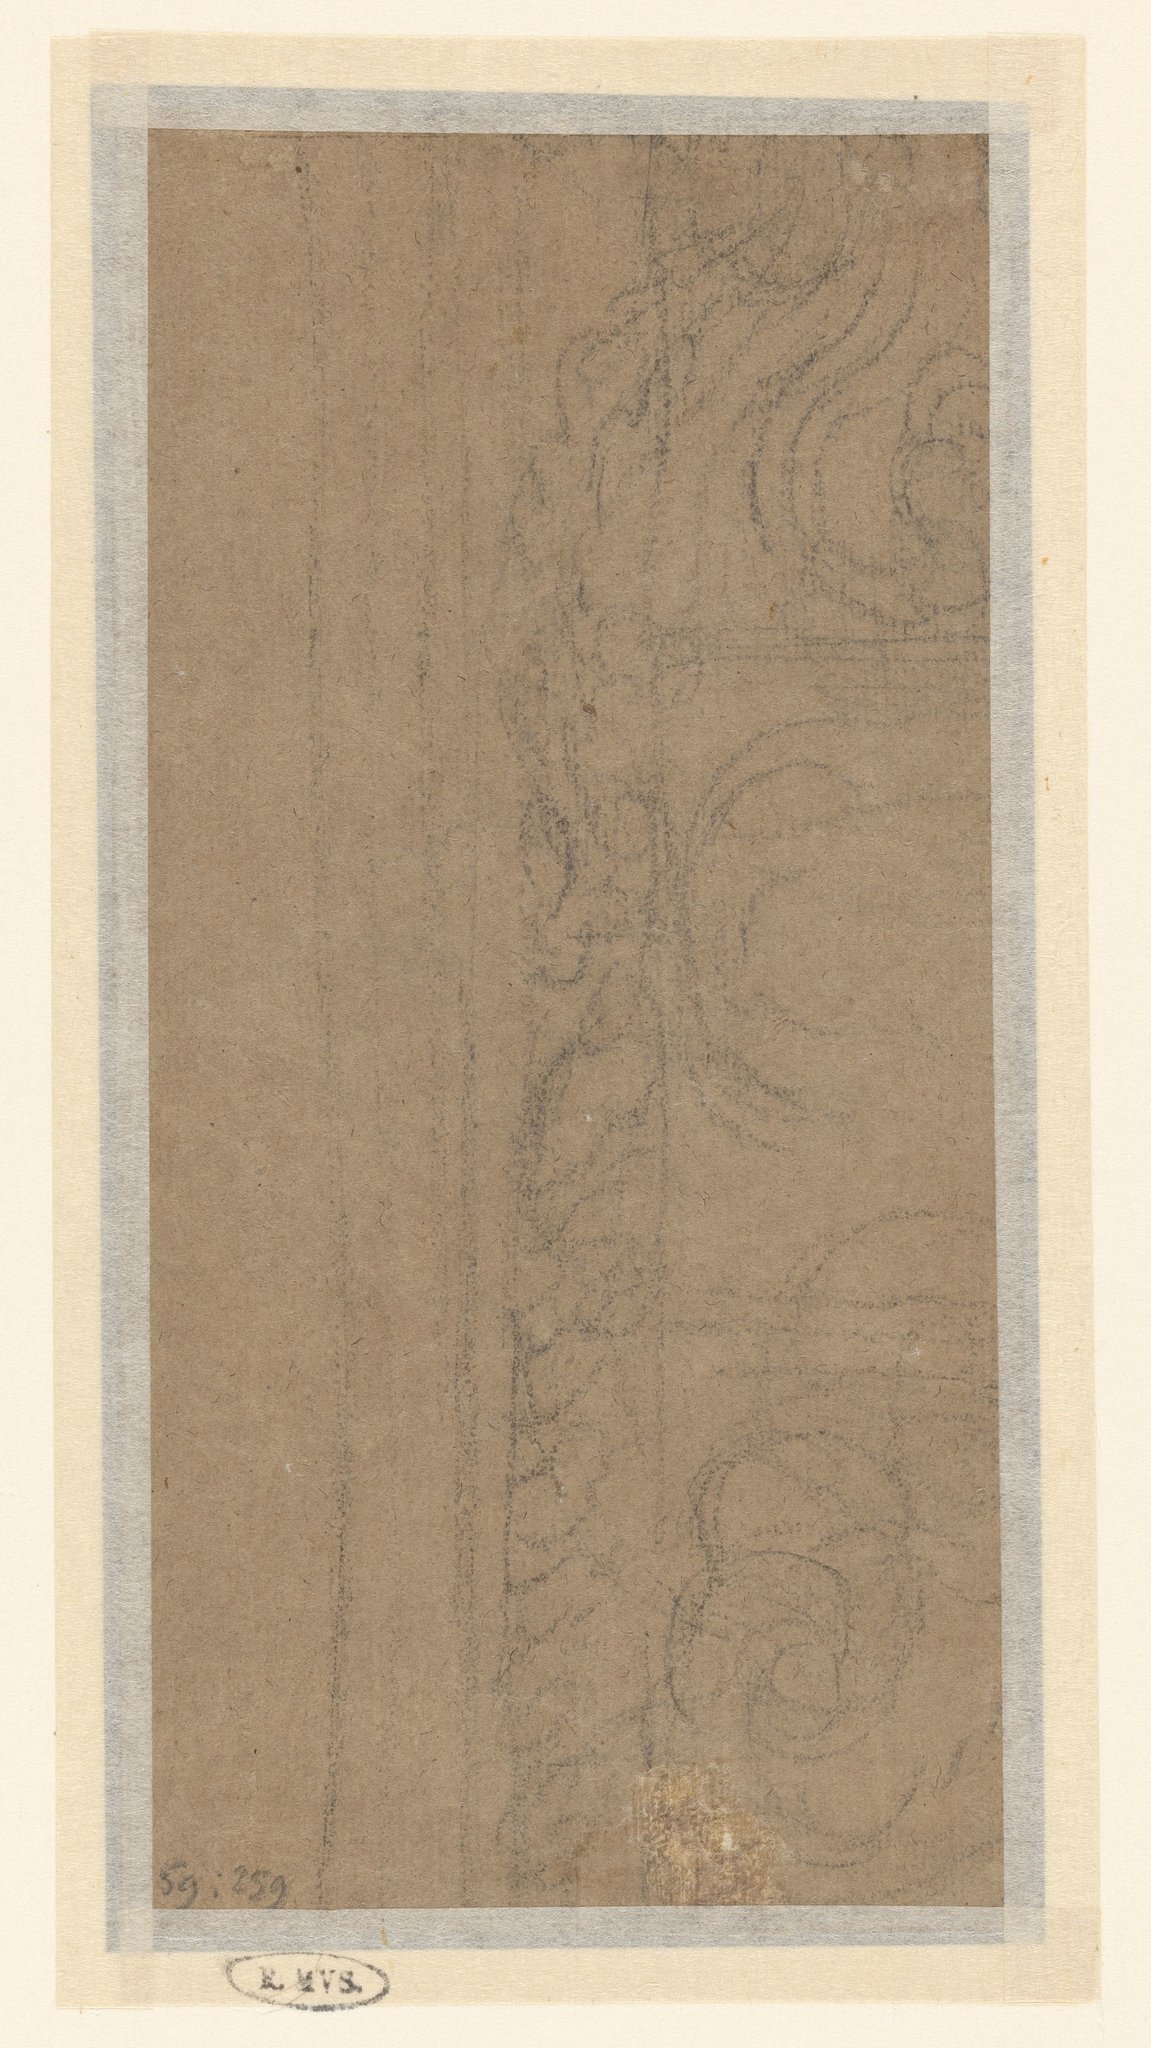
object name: ornamenttekening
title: Deel van een ornament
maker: Anonymous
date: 1580-1620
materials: chalk, paper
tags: ornaments ~ art